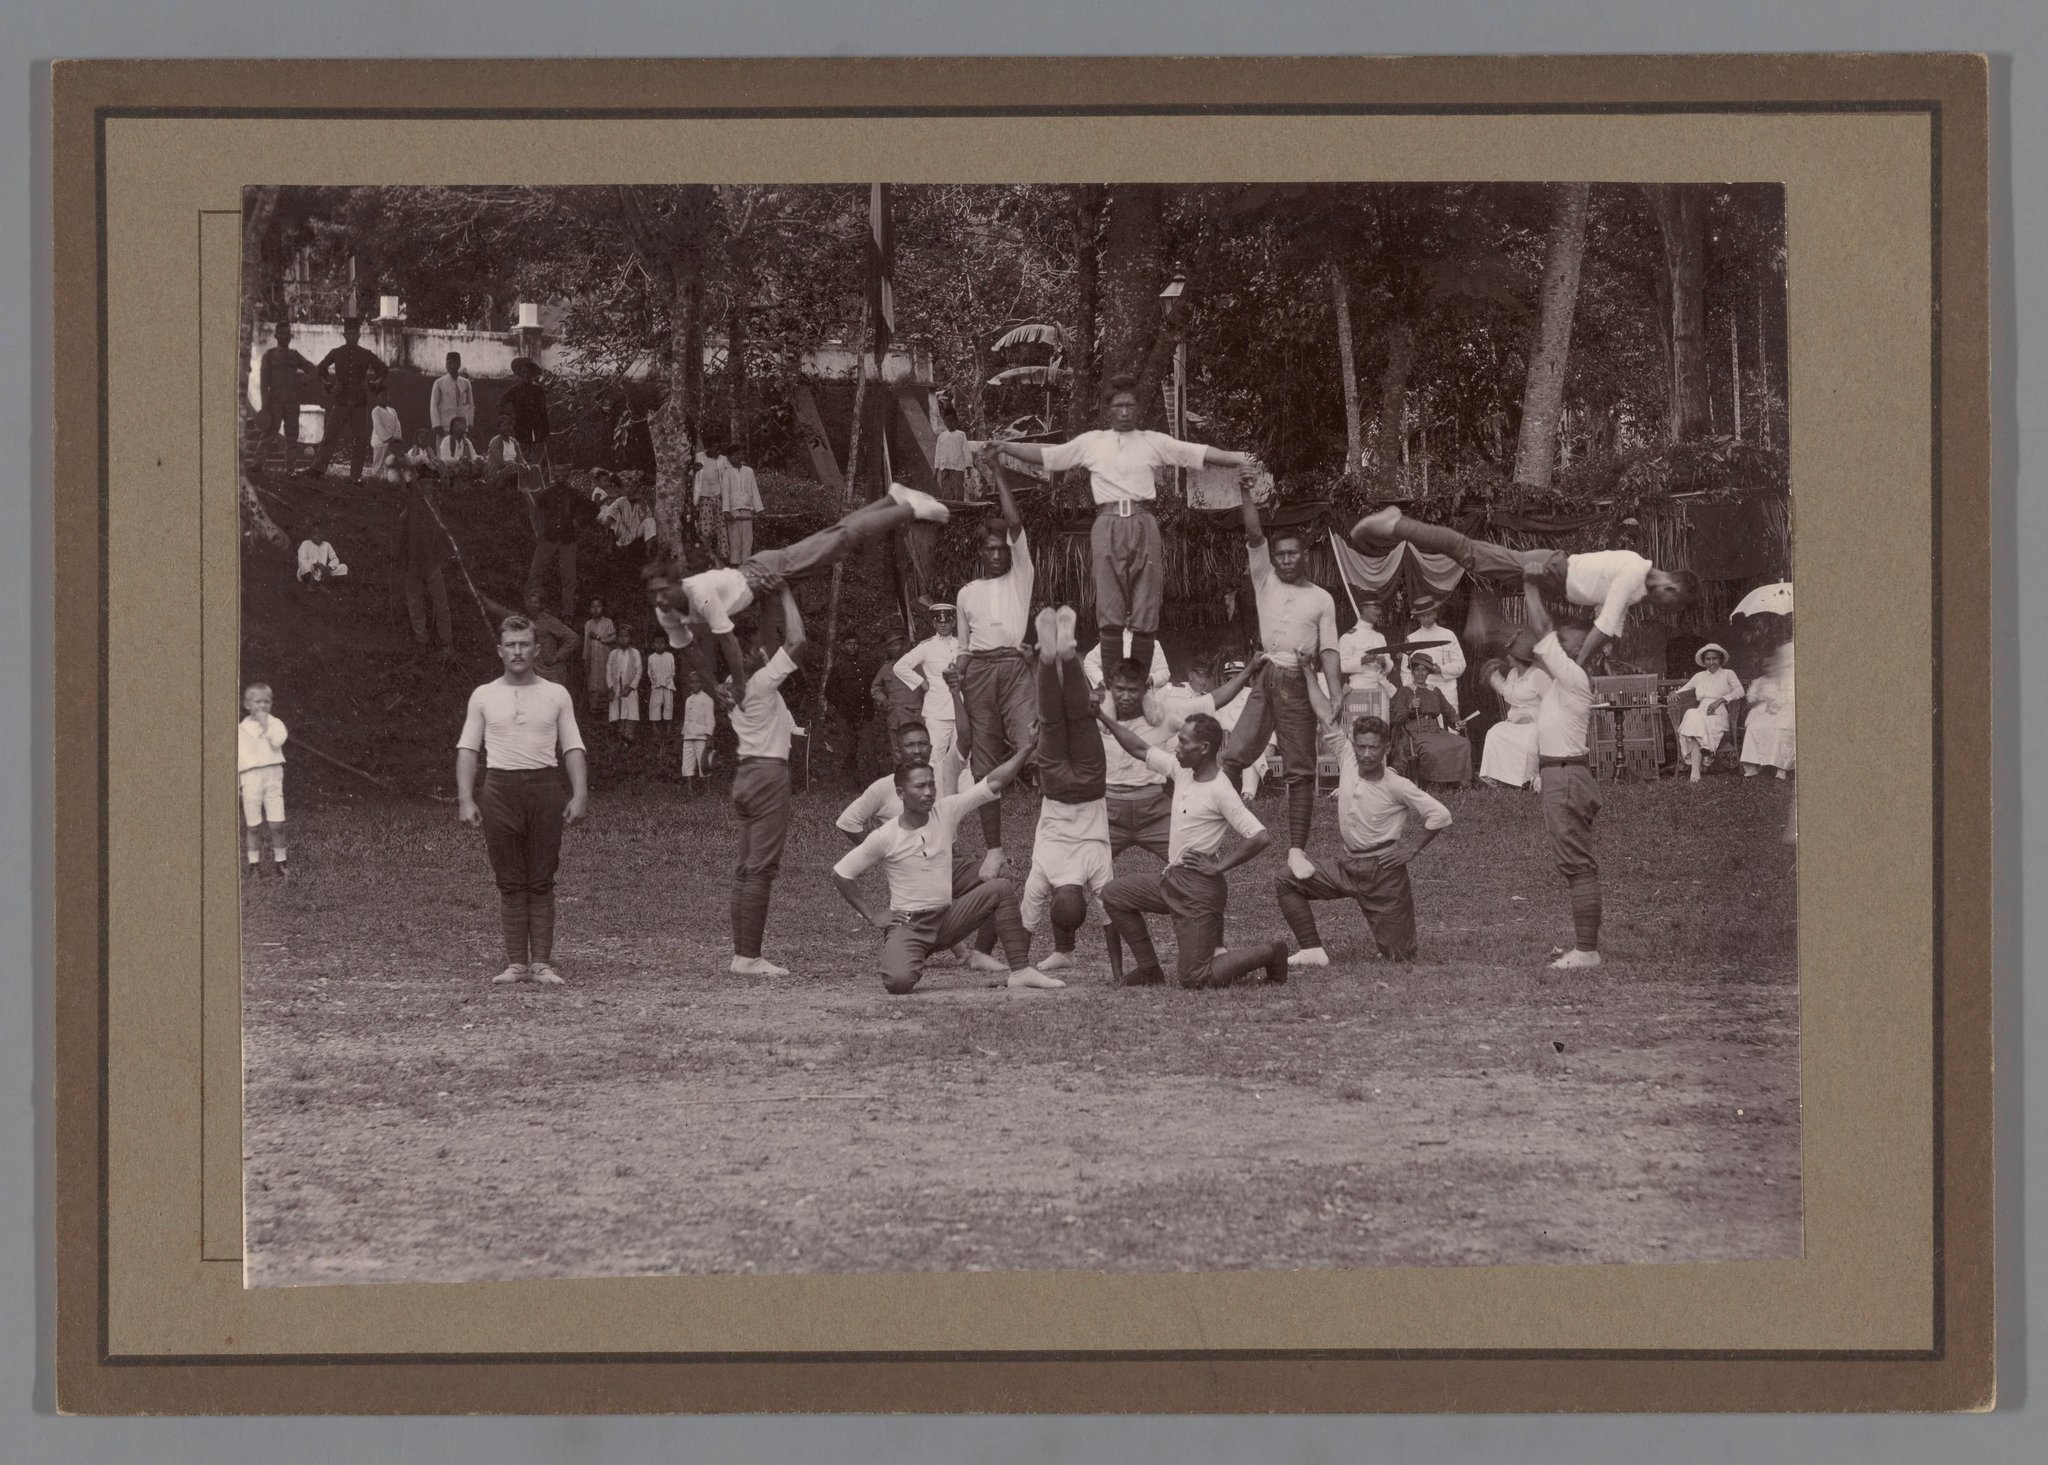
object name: photograph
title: Garnizoenswedstrijd (vermoedelijk) te Tanjung Pinang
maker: Anonymous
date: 1909-1915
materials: cardboard, photographic support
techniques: gelatin silver print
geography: tanjung pinang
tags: group dancing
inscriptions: inscription: ‘Garnizoenswedstrijden. Tg. Pinang, Sept. '15’